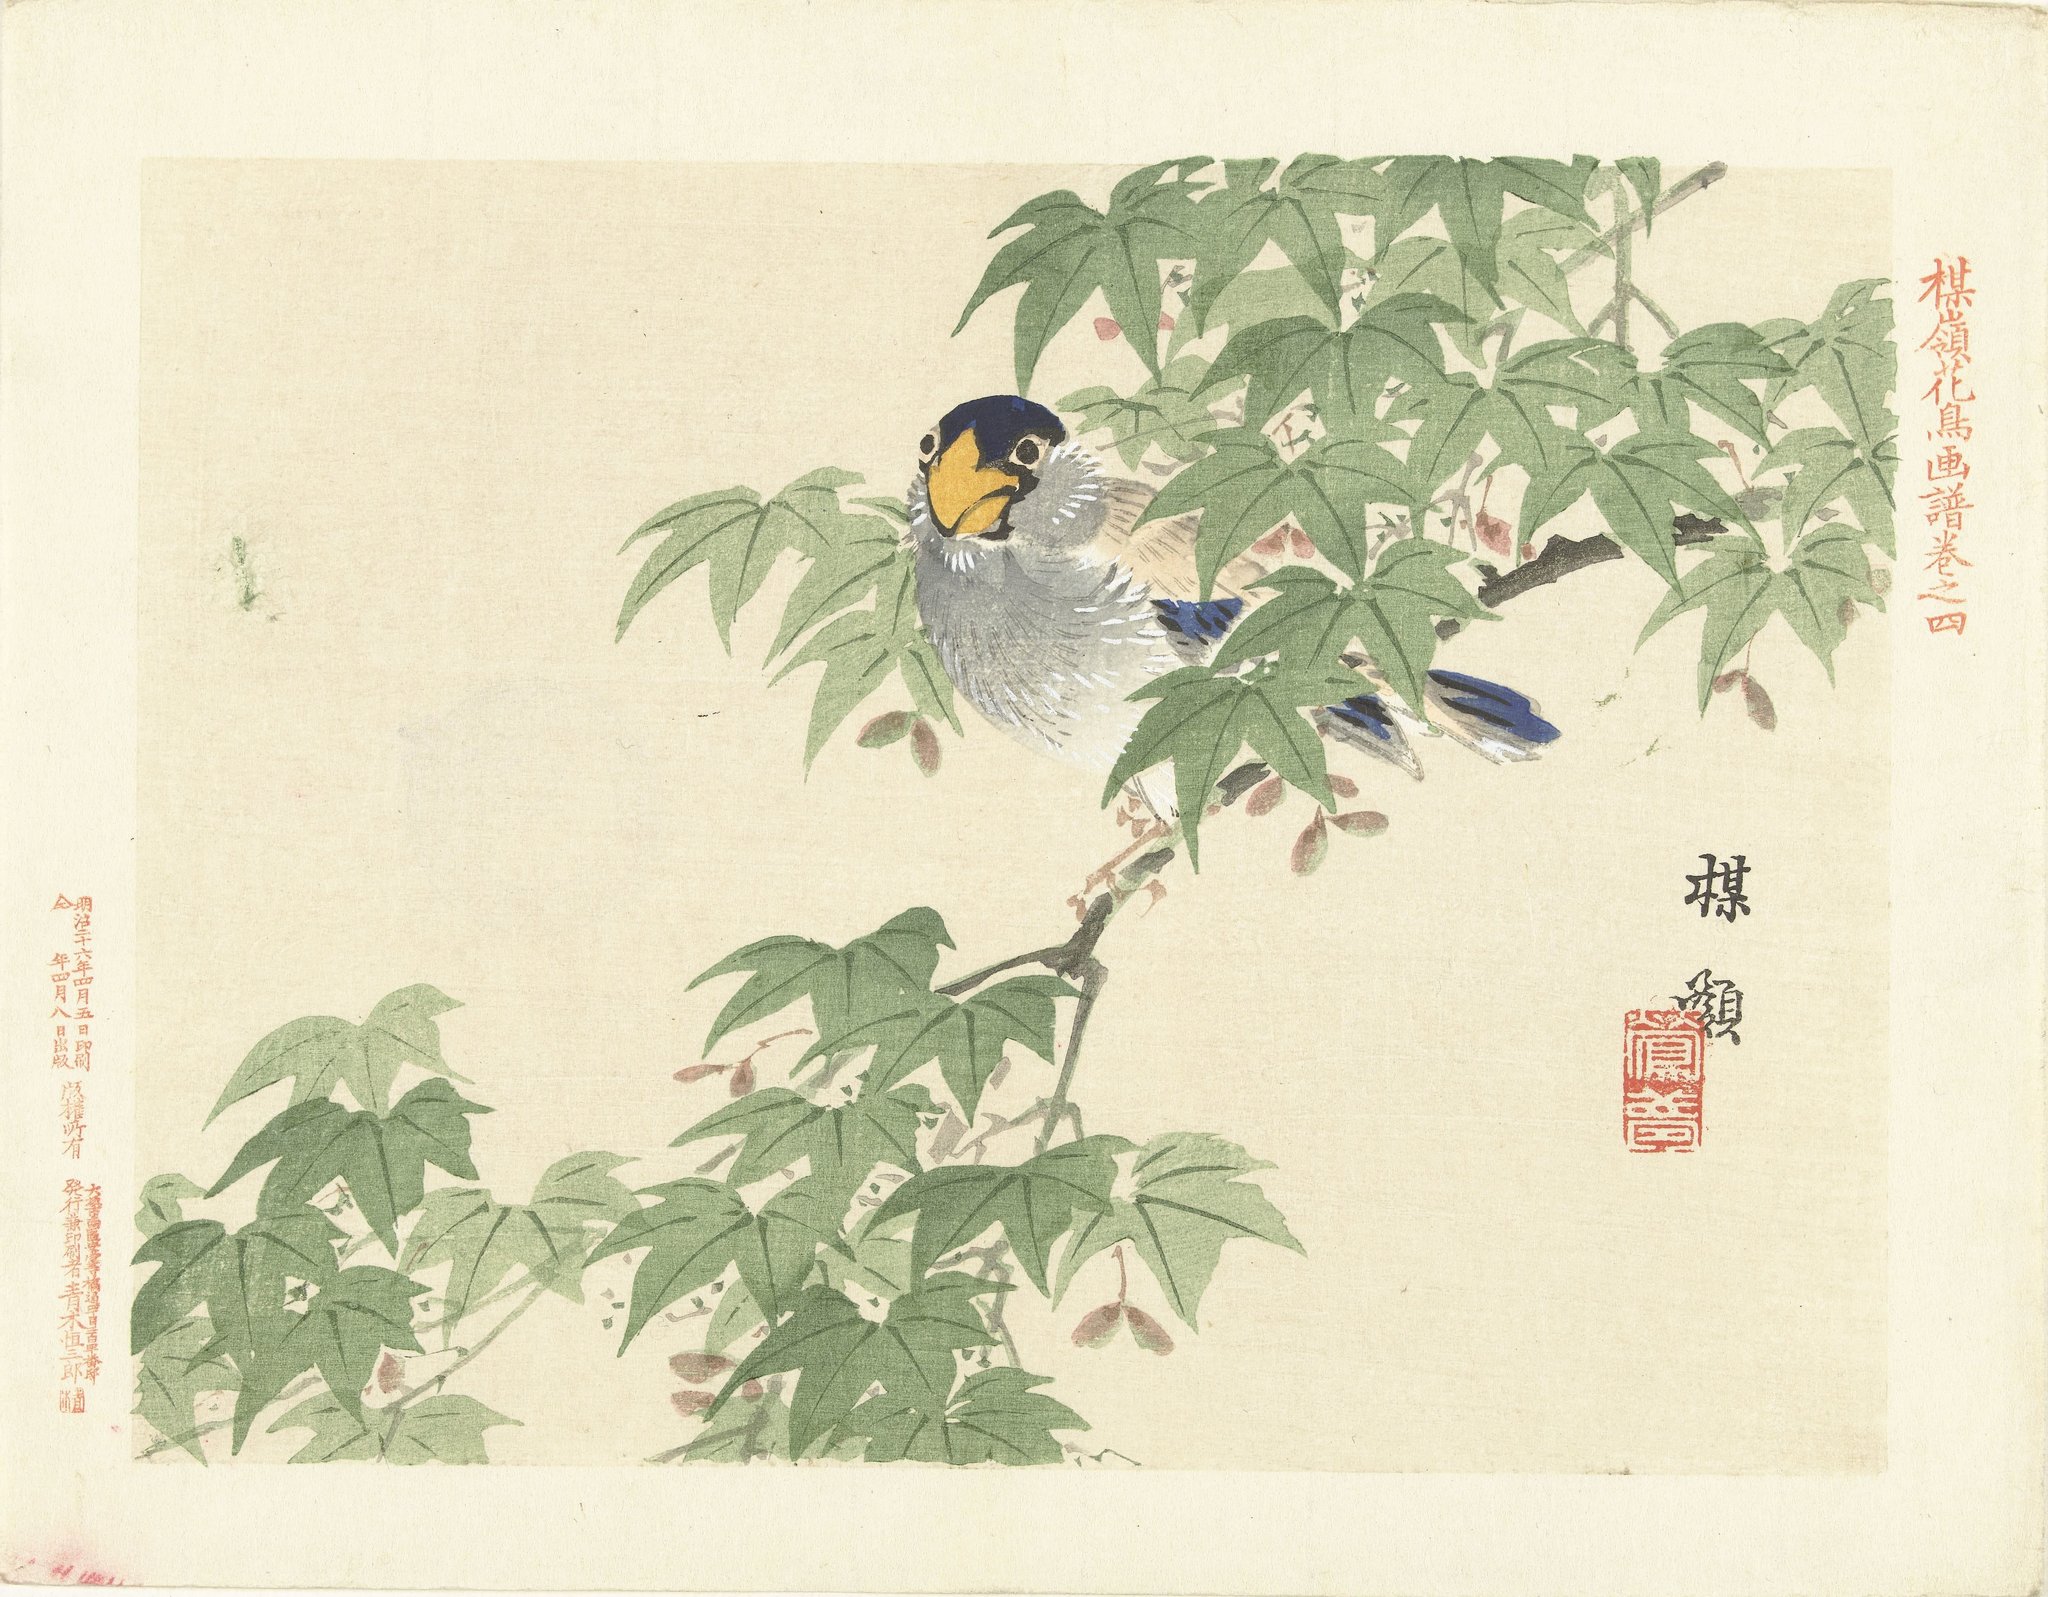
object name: print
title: Grijs-blauwe vogel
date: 1804-1893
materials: paper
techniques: woodcut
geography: osaka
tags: plants; vegetation, birds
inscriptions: collector's mark: ‘Rijksschool voor kunstnijverheid’ Lugt 3937, collector's mark: Lugt 2228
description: Grijs-blauwe vogel met grote gele snavel, op tak tussen groene bladeren.